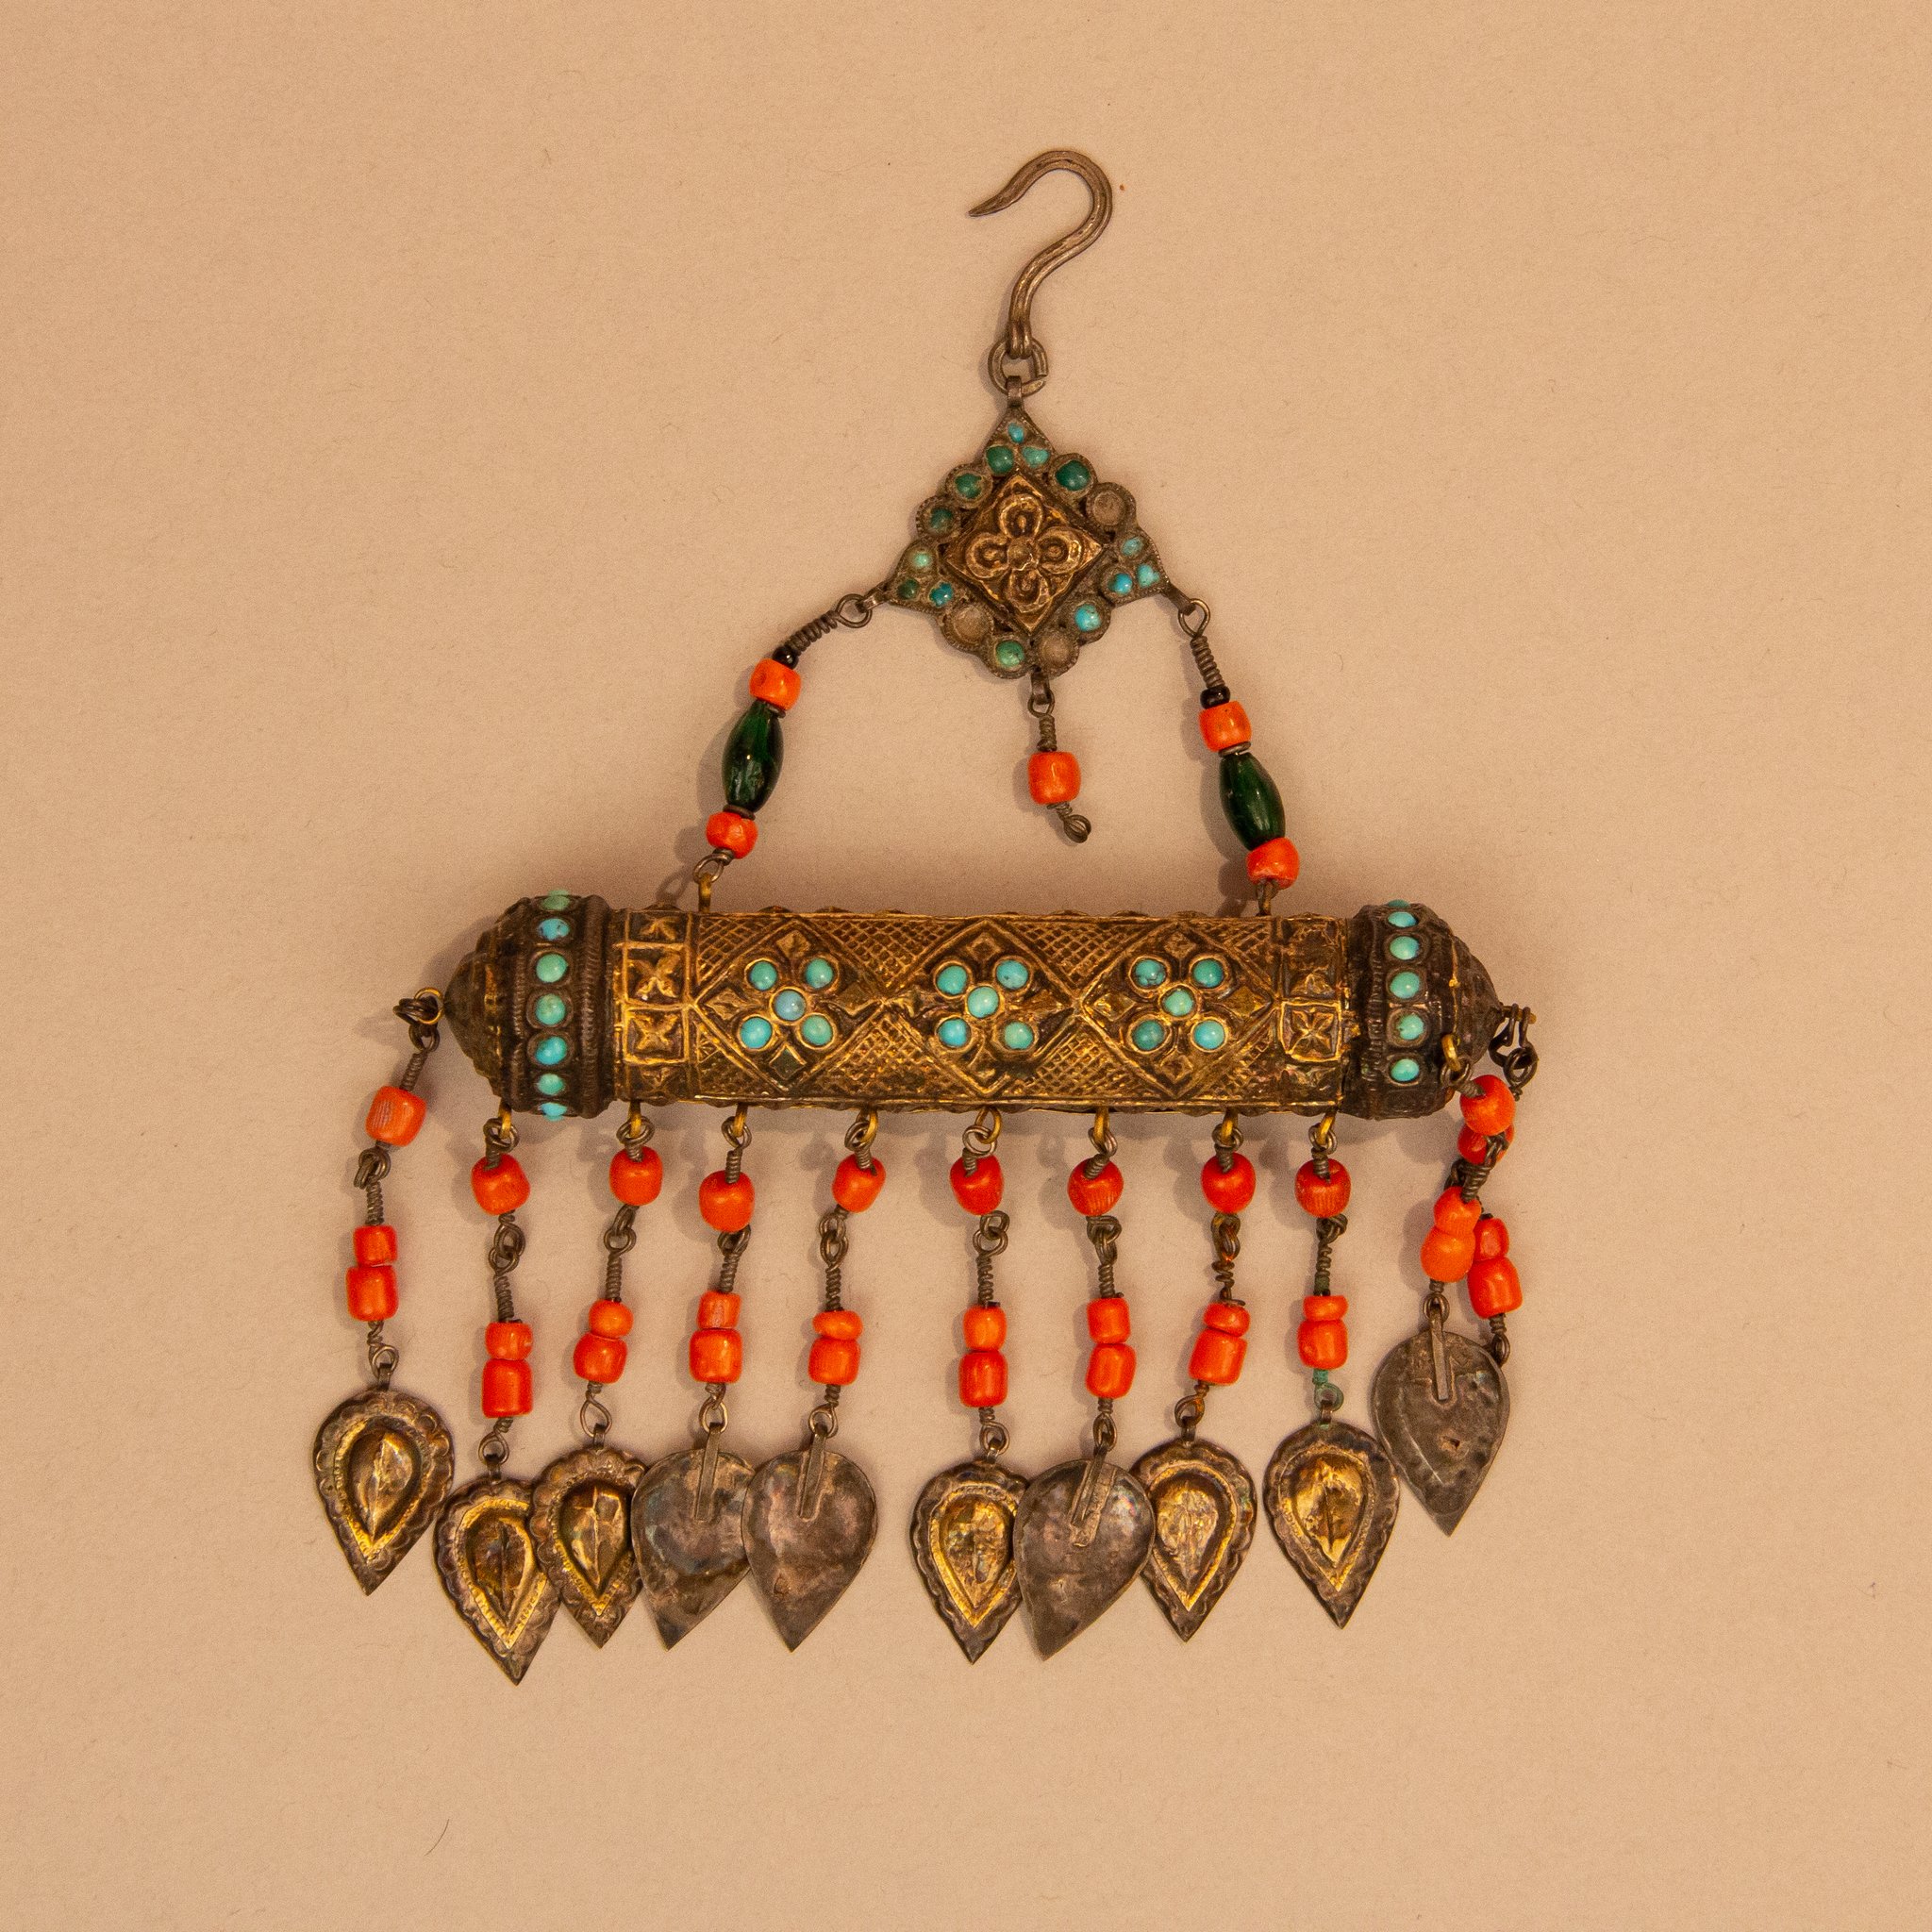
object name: amulet case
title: Amulet Case, One of a Pair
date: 1801-1900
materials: coral, glass, silver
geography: uzbekistan